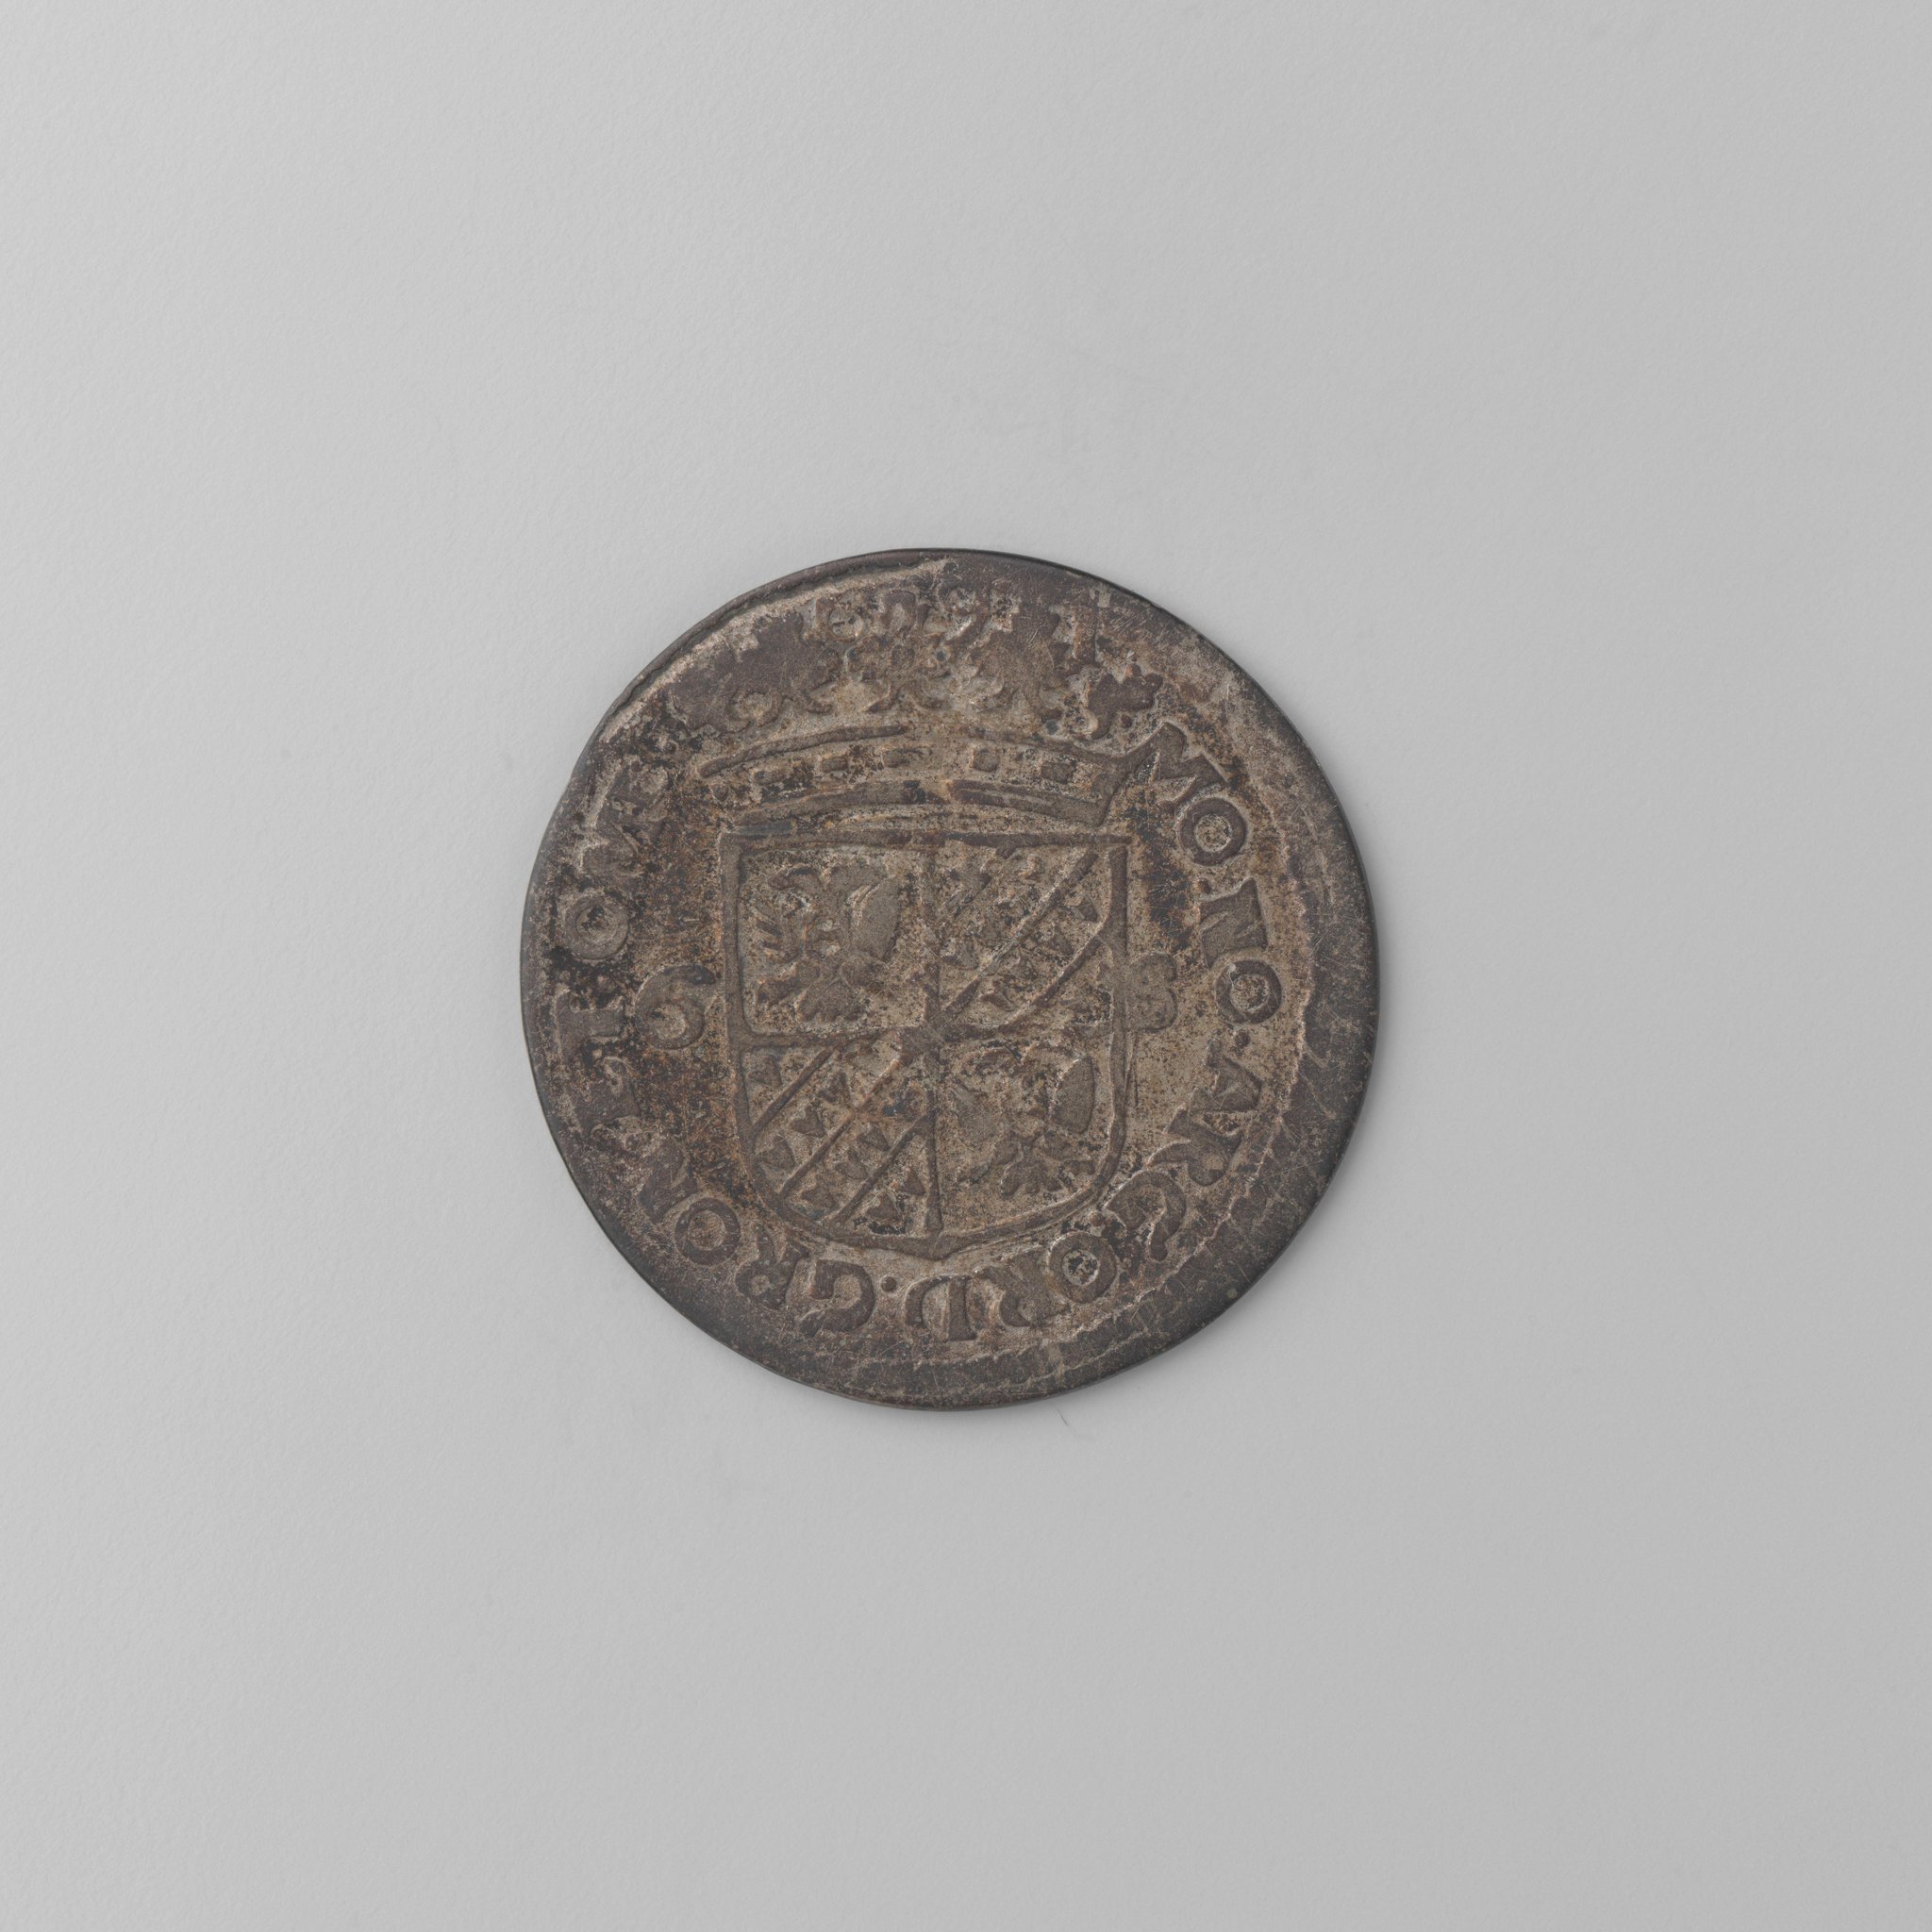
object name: coin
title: Ruiterschelling van Groningen en de Ommelanden, 1691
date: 1691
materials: silver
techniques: striking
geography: groningen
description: Zilveren munt. Voorzijde: tussen waarde-aanduiding 6 S gekrooond wapenschild. Jaartal boven kroon. Keerzijde: ridder te paard met zwaard naar rechts.